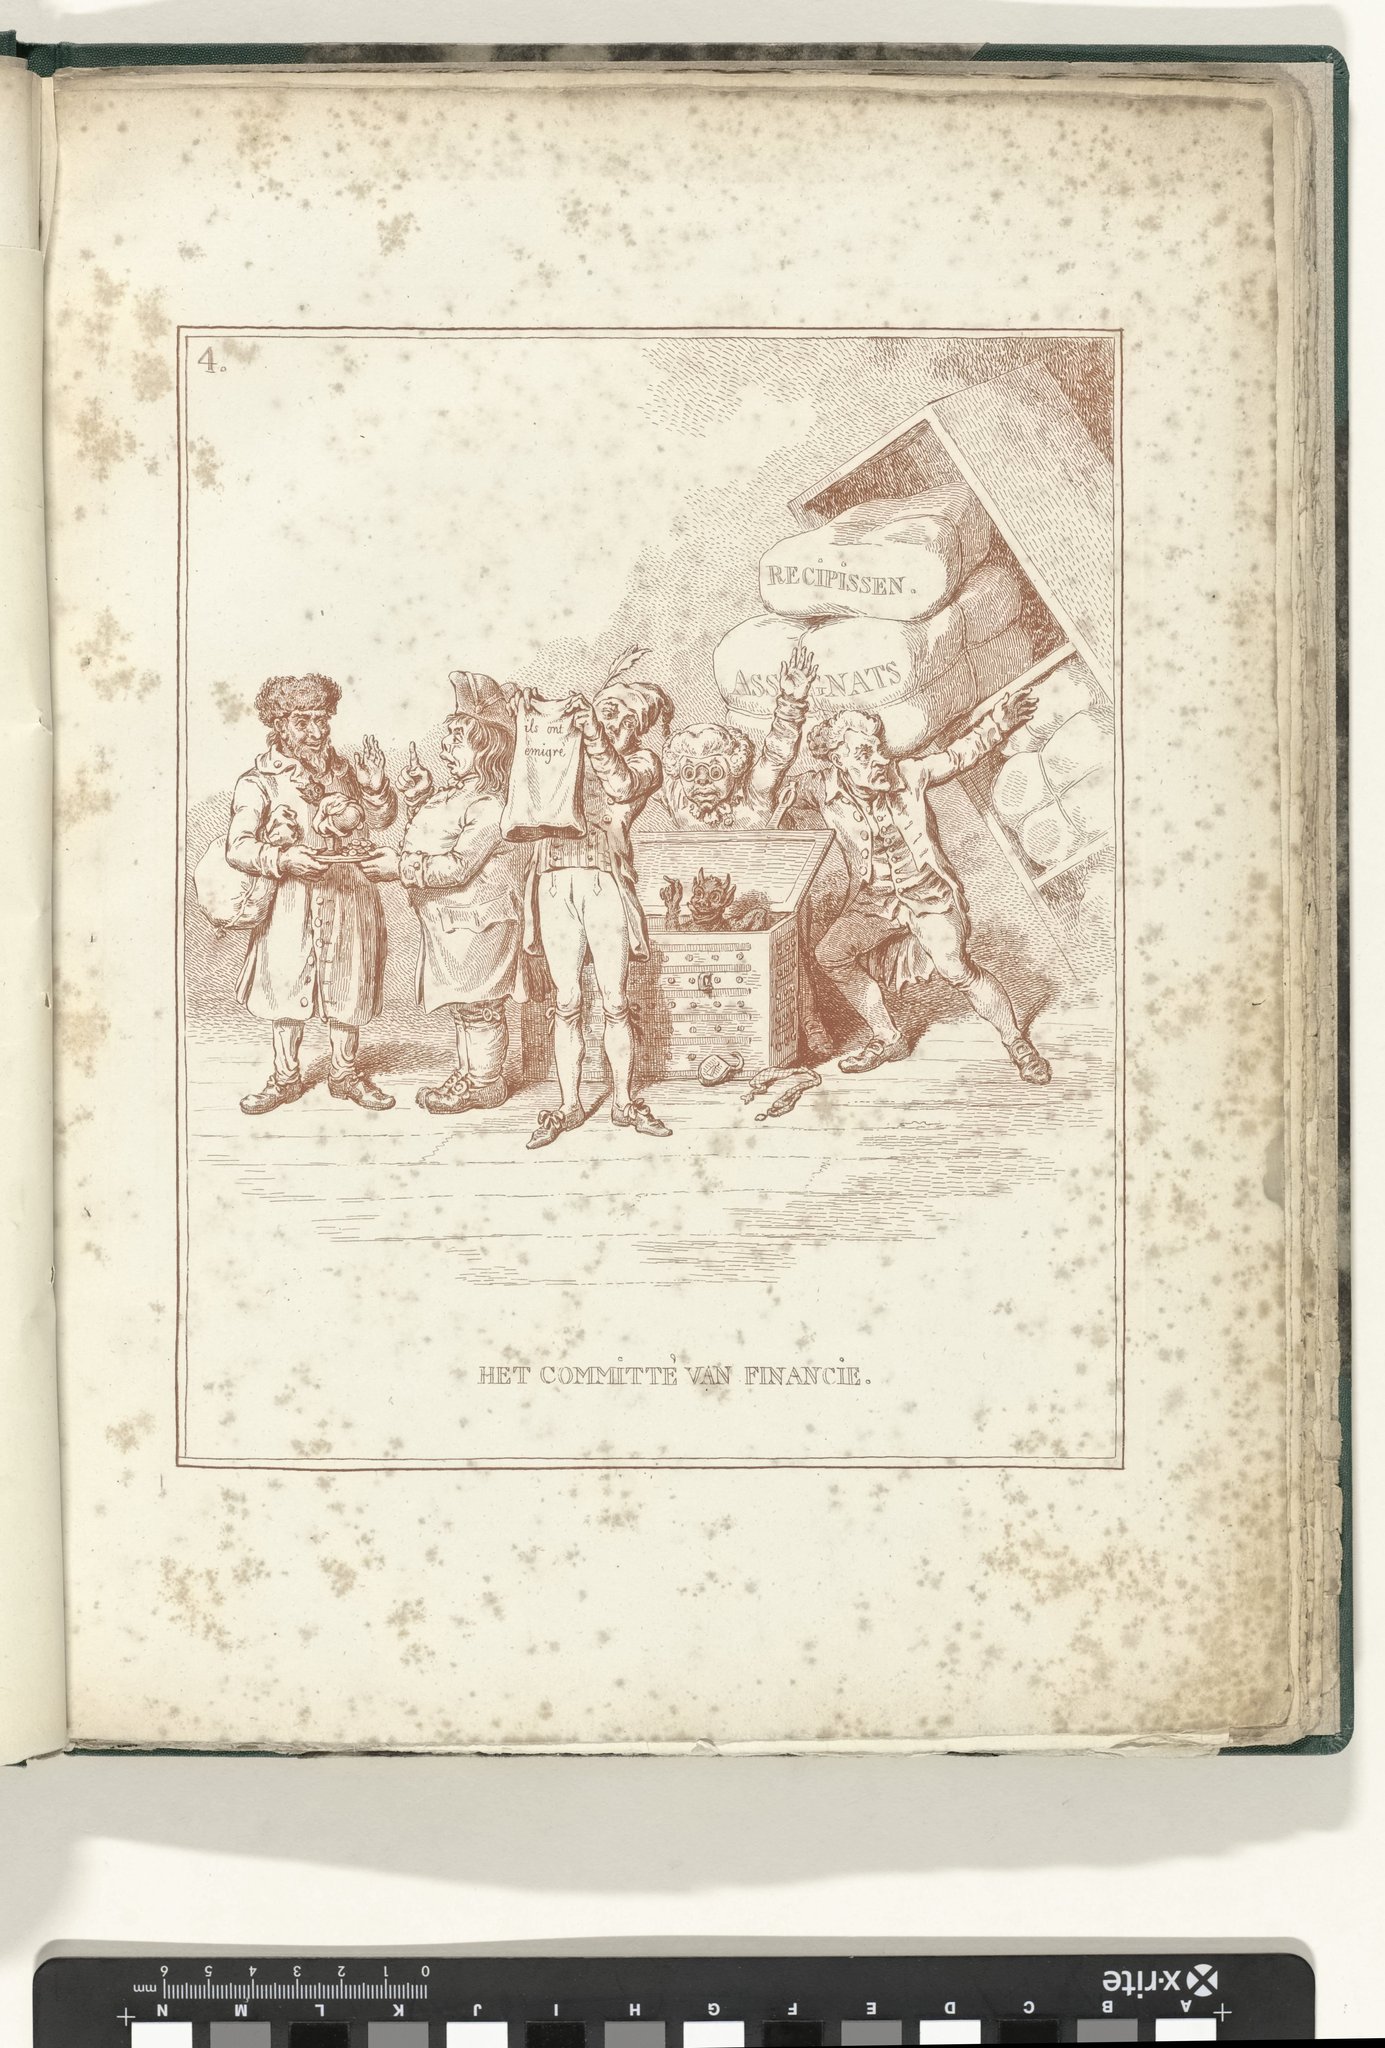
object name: print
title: Comité van Financiën, 1795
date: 1795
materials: paper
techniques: etching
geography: london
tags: bankruptcy, anti-semitic insinuations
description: Onderdeel van een in boekvorm uitgegeven serie van twintig spotprenten op de Provisionele Representanten van het Volk van Holland en de Bataafse Republiek in het algemeen in het jaar 1795. De serietitel 'Hollandia Regenerata' staat vermeld op de titelprent. Elke prent gevolgd door een tekstblad met een Bijbelcitaat in het Nederlands, een verklaring in het Frans en het Bijbelcitaat in het Engels. Waarschijnlijk uitgegeven in Londen door William Humphrey in 1795.